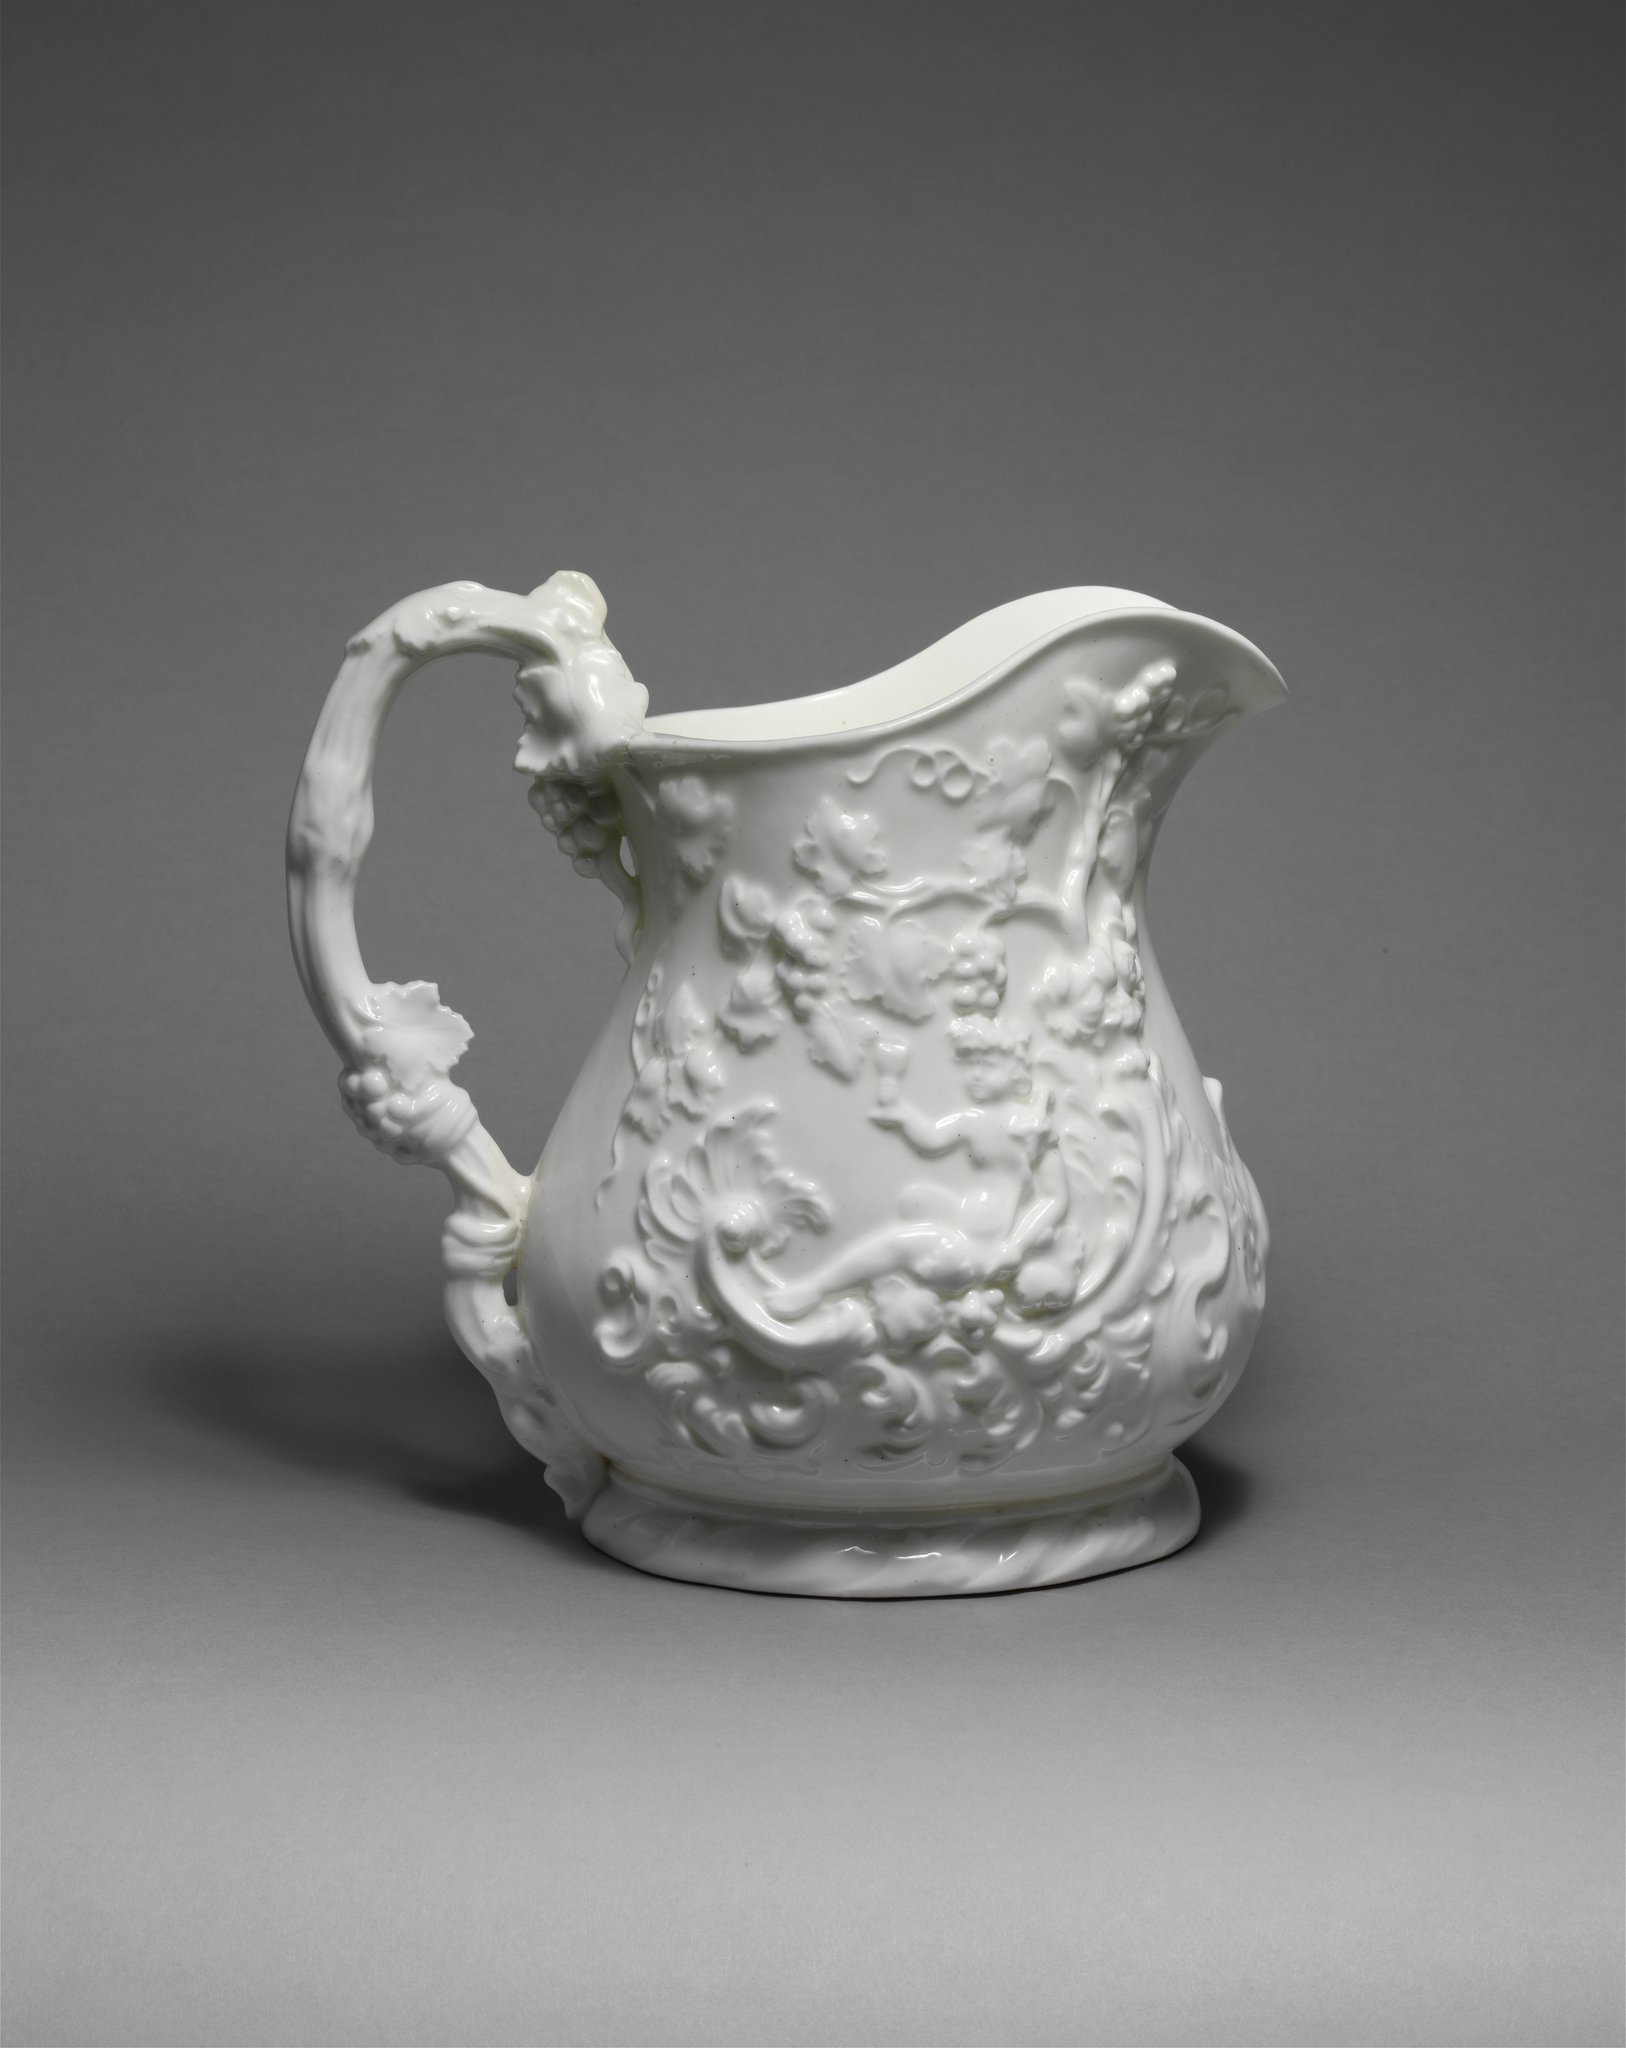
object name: pitcher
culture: american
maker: william boch and brothers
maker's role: maker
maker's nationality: american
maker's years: 1844-1862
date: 1844-1857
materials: porcelain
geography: united states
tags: grapes,putti